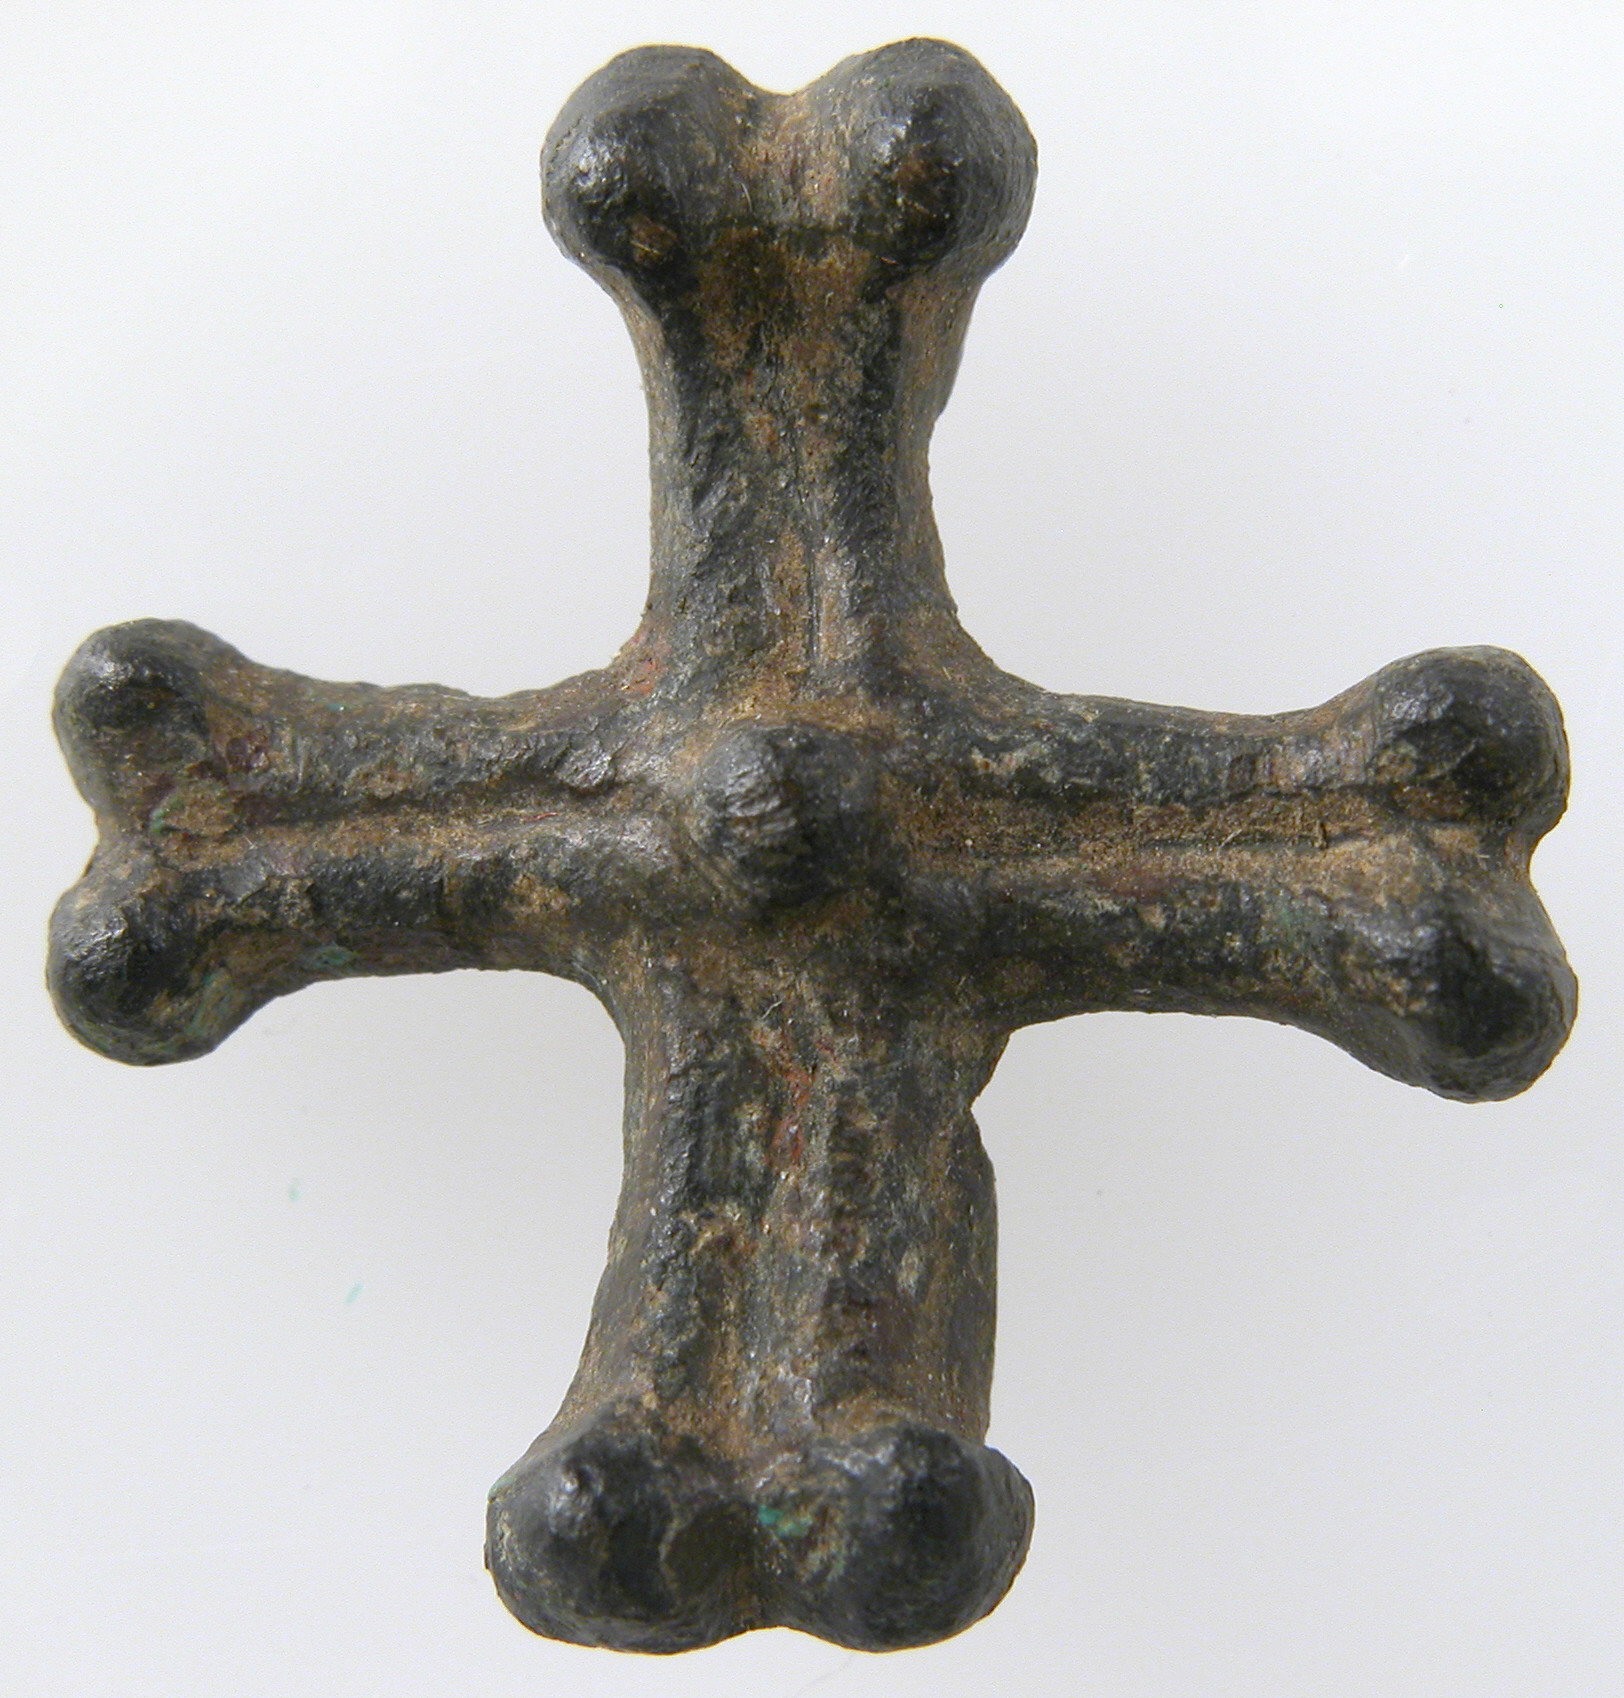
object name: cross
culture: carolingian or merovingian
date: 701-900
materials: copper alloy, enamel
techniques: enamel